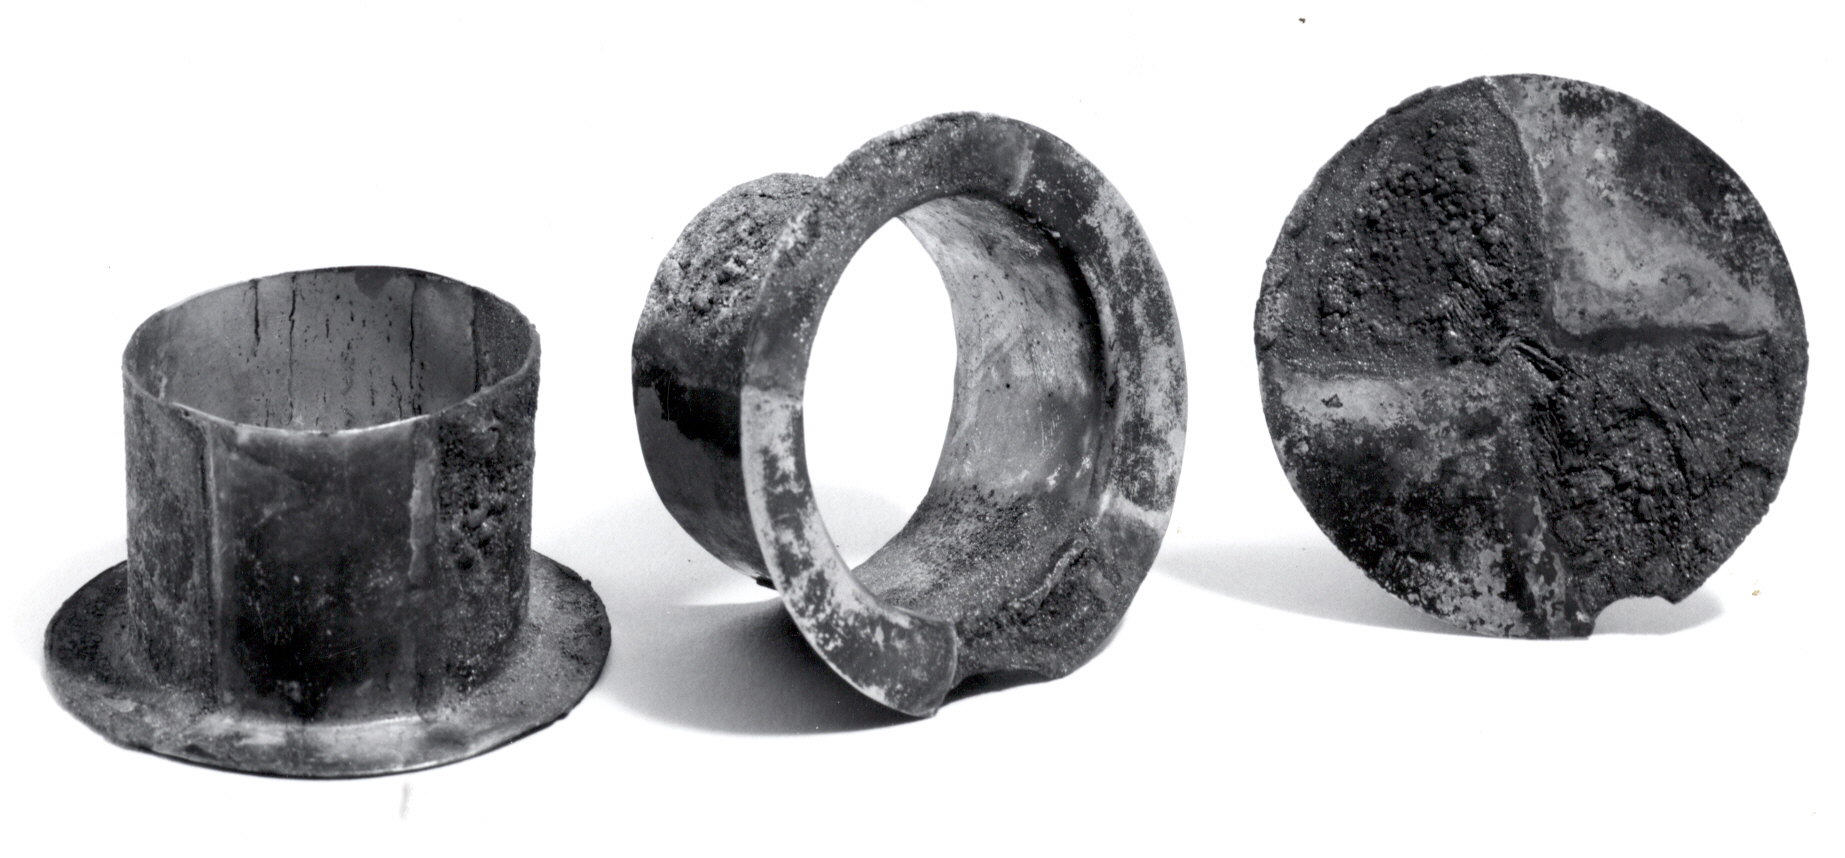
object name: earflare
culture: lambayeque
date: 100 BCE-700 CE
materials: gold, silver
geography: peru